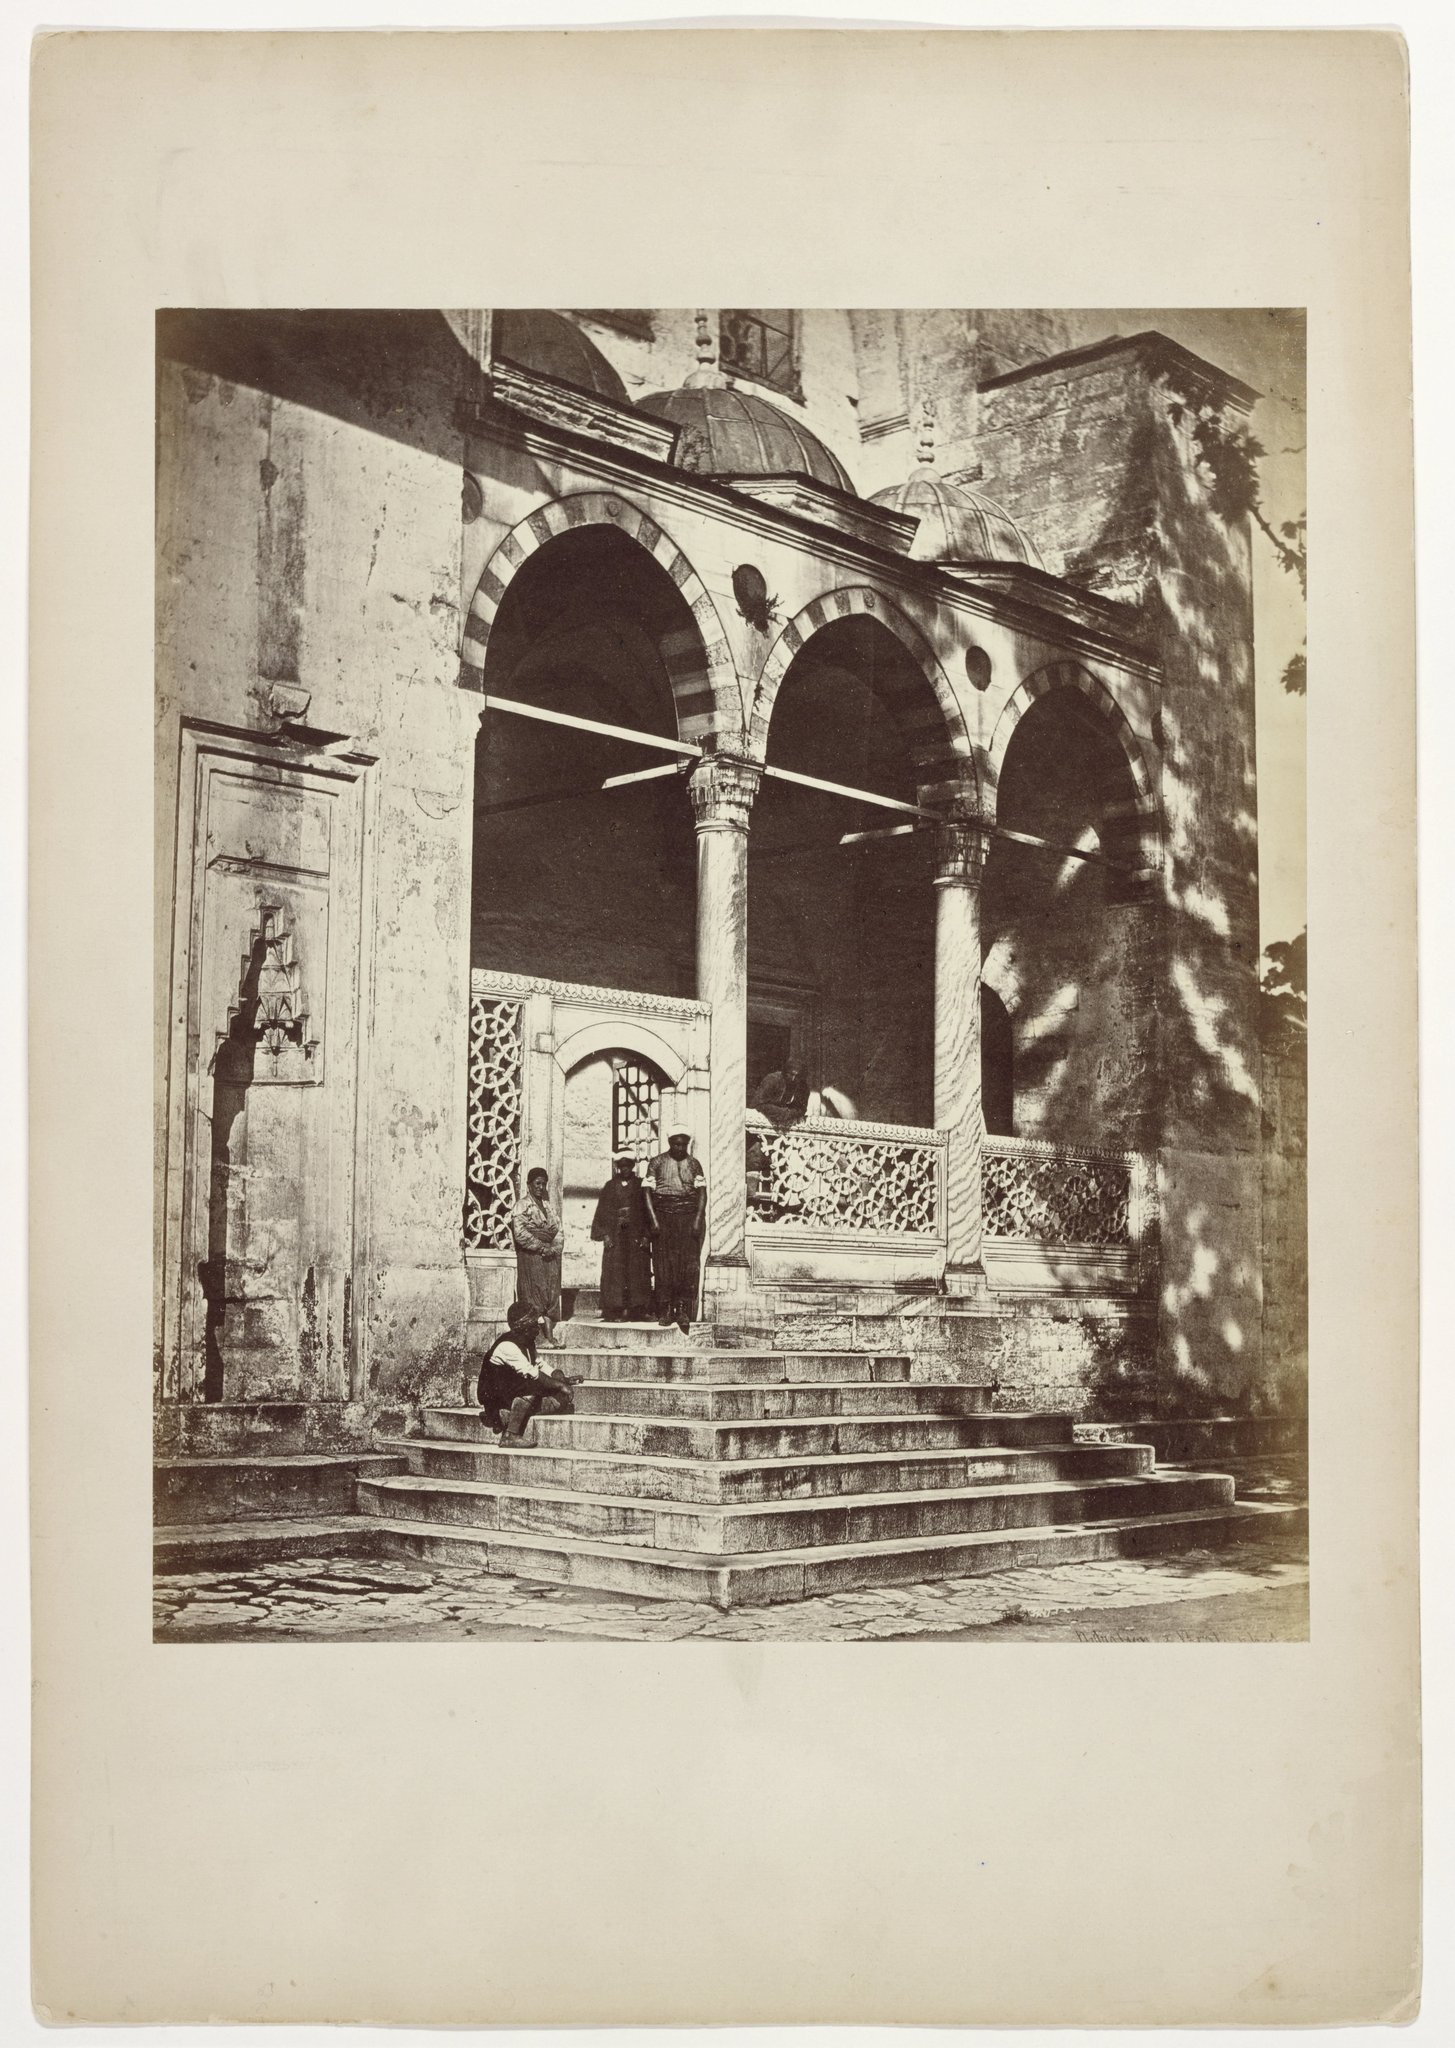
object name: photograph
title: Portaal van de Süleymaniye-moskee in Istanboel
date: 1854-1867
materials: cardboard, paper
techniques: albumen print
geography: istanbul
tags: temple, shrine ~ islam, mohammedanism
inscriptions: inscription: ‘Constantinople/ Portico of the/ Sulimanié’, inscription: ‘Robertson & Beato phot.’